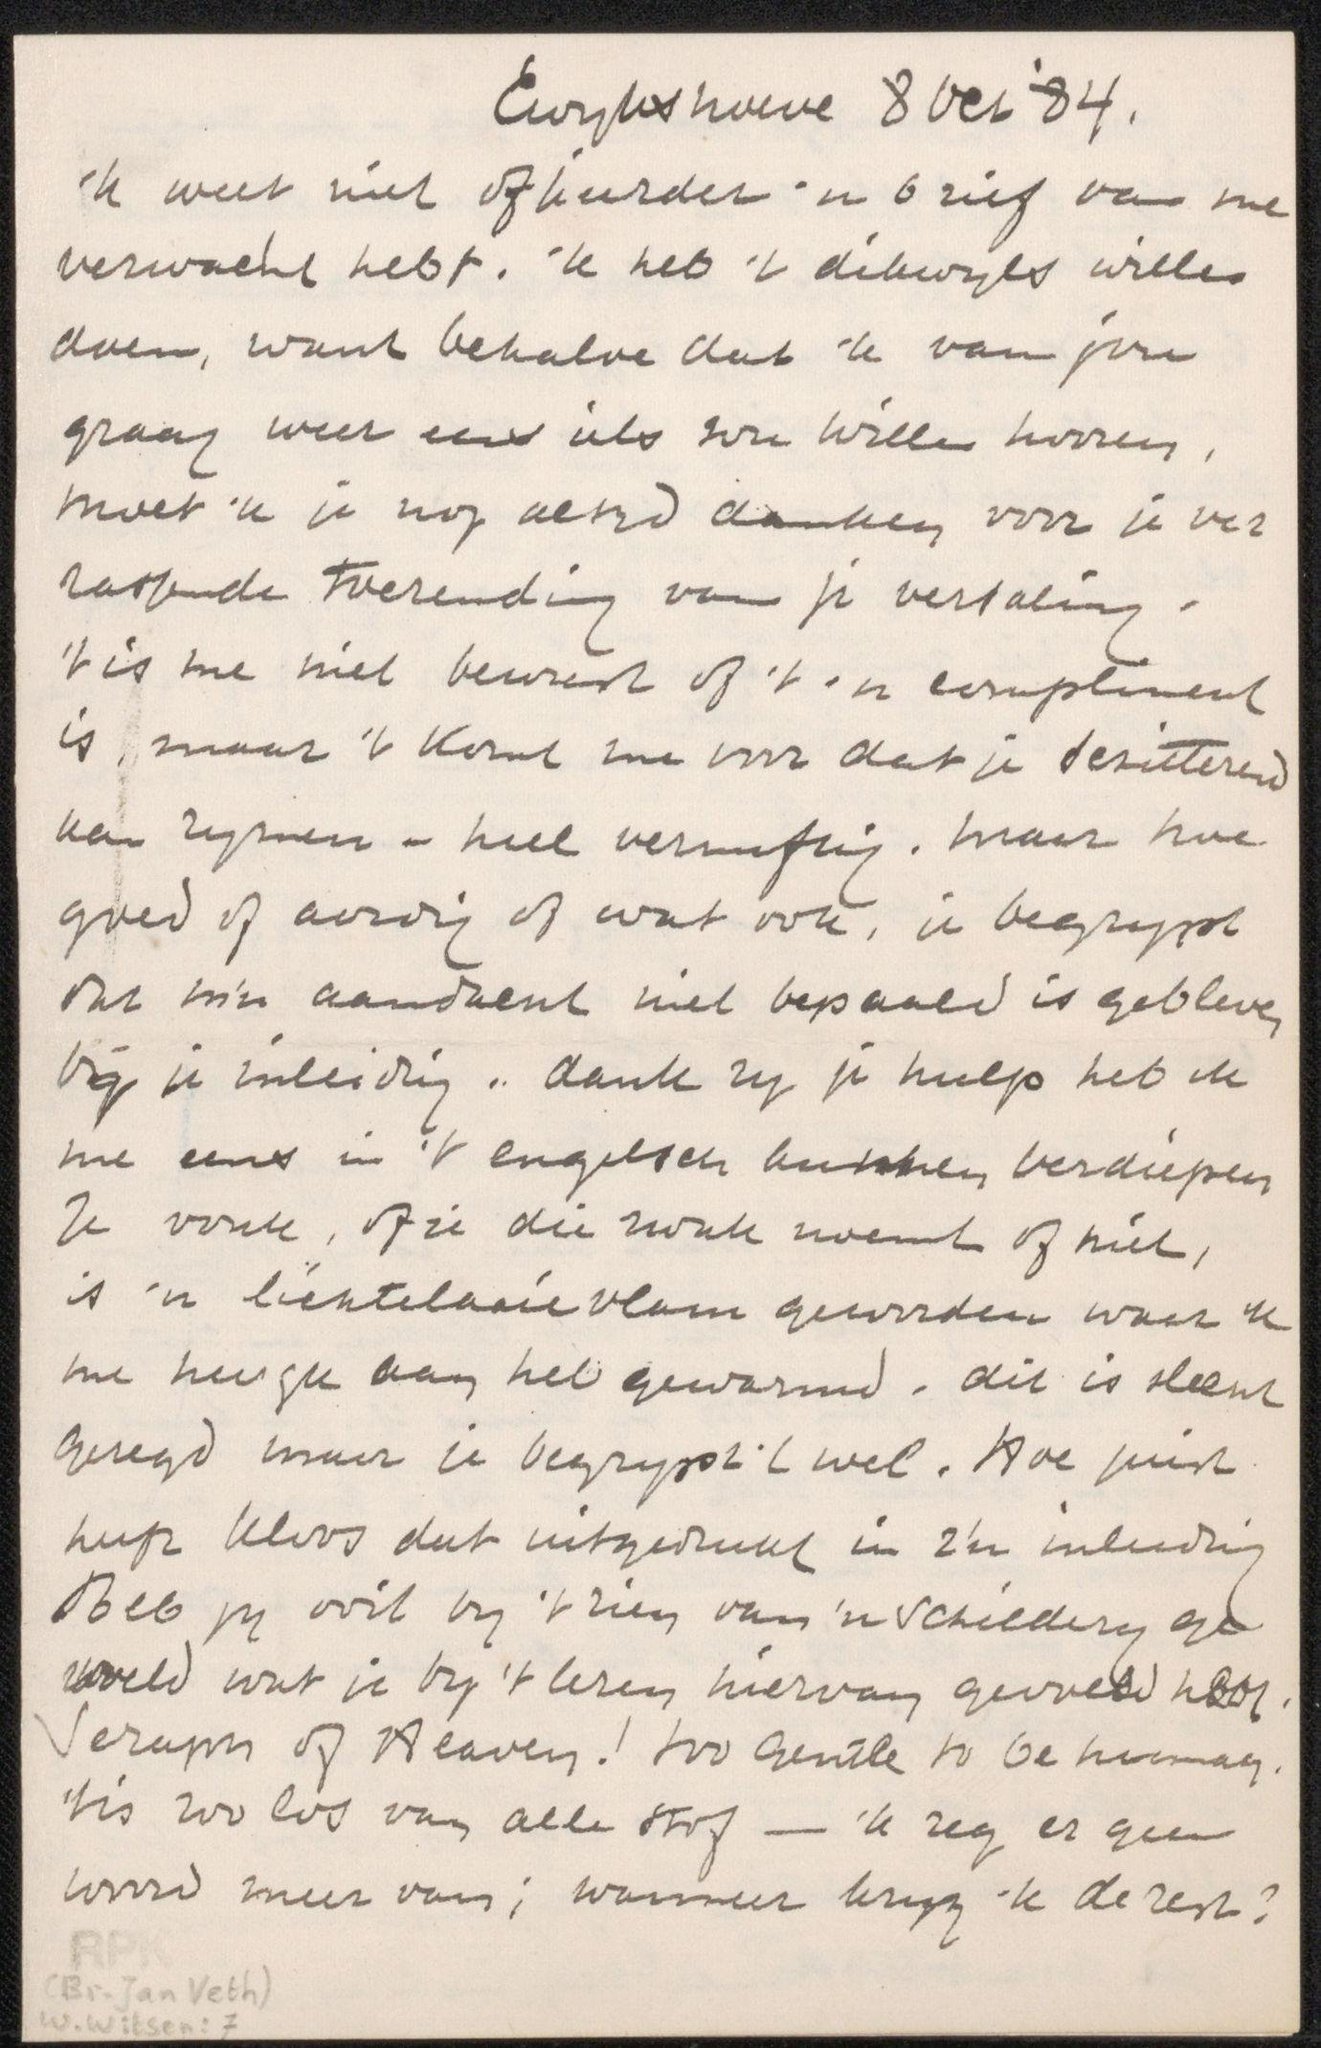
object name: letter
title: Brief aan Jan Veth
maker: willem witsen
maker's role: draughtsman, painter, print maker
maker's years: 1860-1923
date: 1884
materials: ink, paper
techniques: pen, writing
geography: ewijkshoeve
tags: hendrik jacobus scholten, dordrecht, painter, print maker, draughtsman, designer, jan veth, arnhem, anton mauve, haarlem, jac van looij, the hague, willem kloos, chap van deventer, albert verwey, johannes verhulst, passions, emotions, affections, literature ~ arts, painting (including book-illumination, miniature-painting), exhibition ~ art, brussels, paris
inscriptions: collector's mark: ‘RPK’, watermark